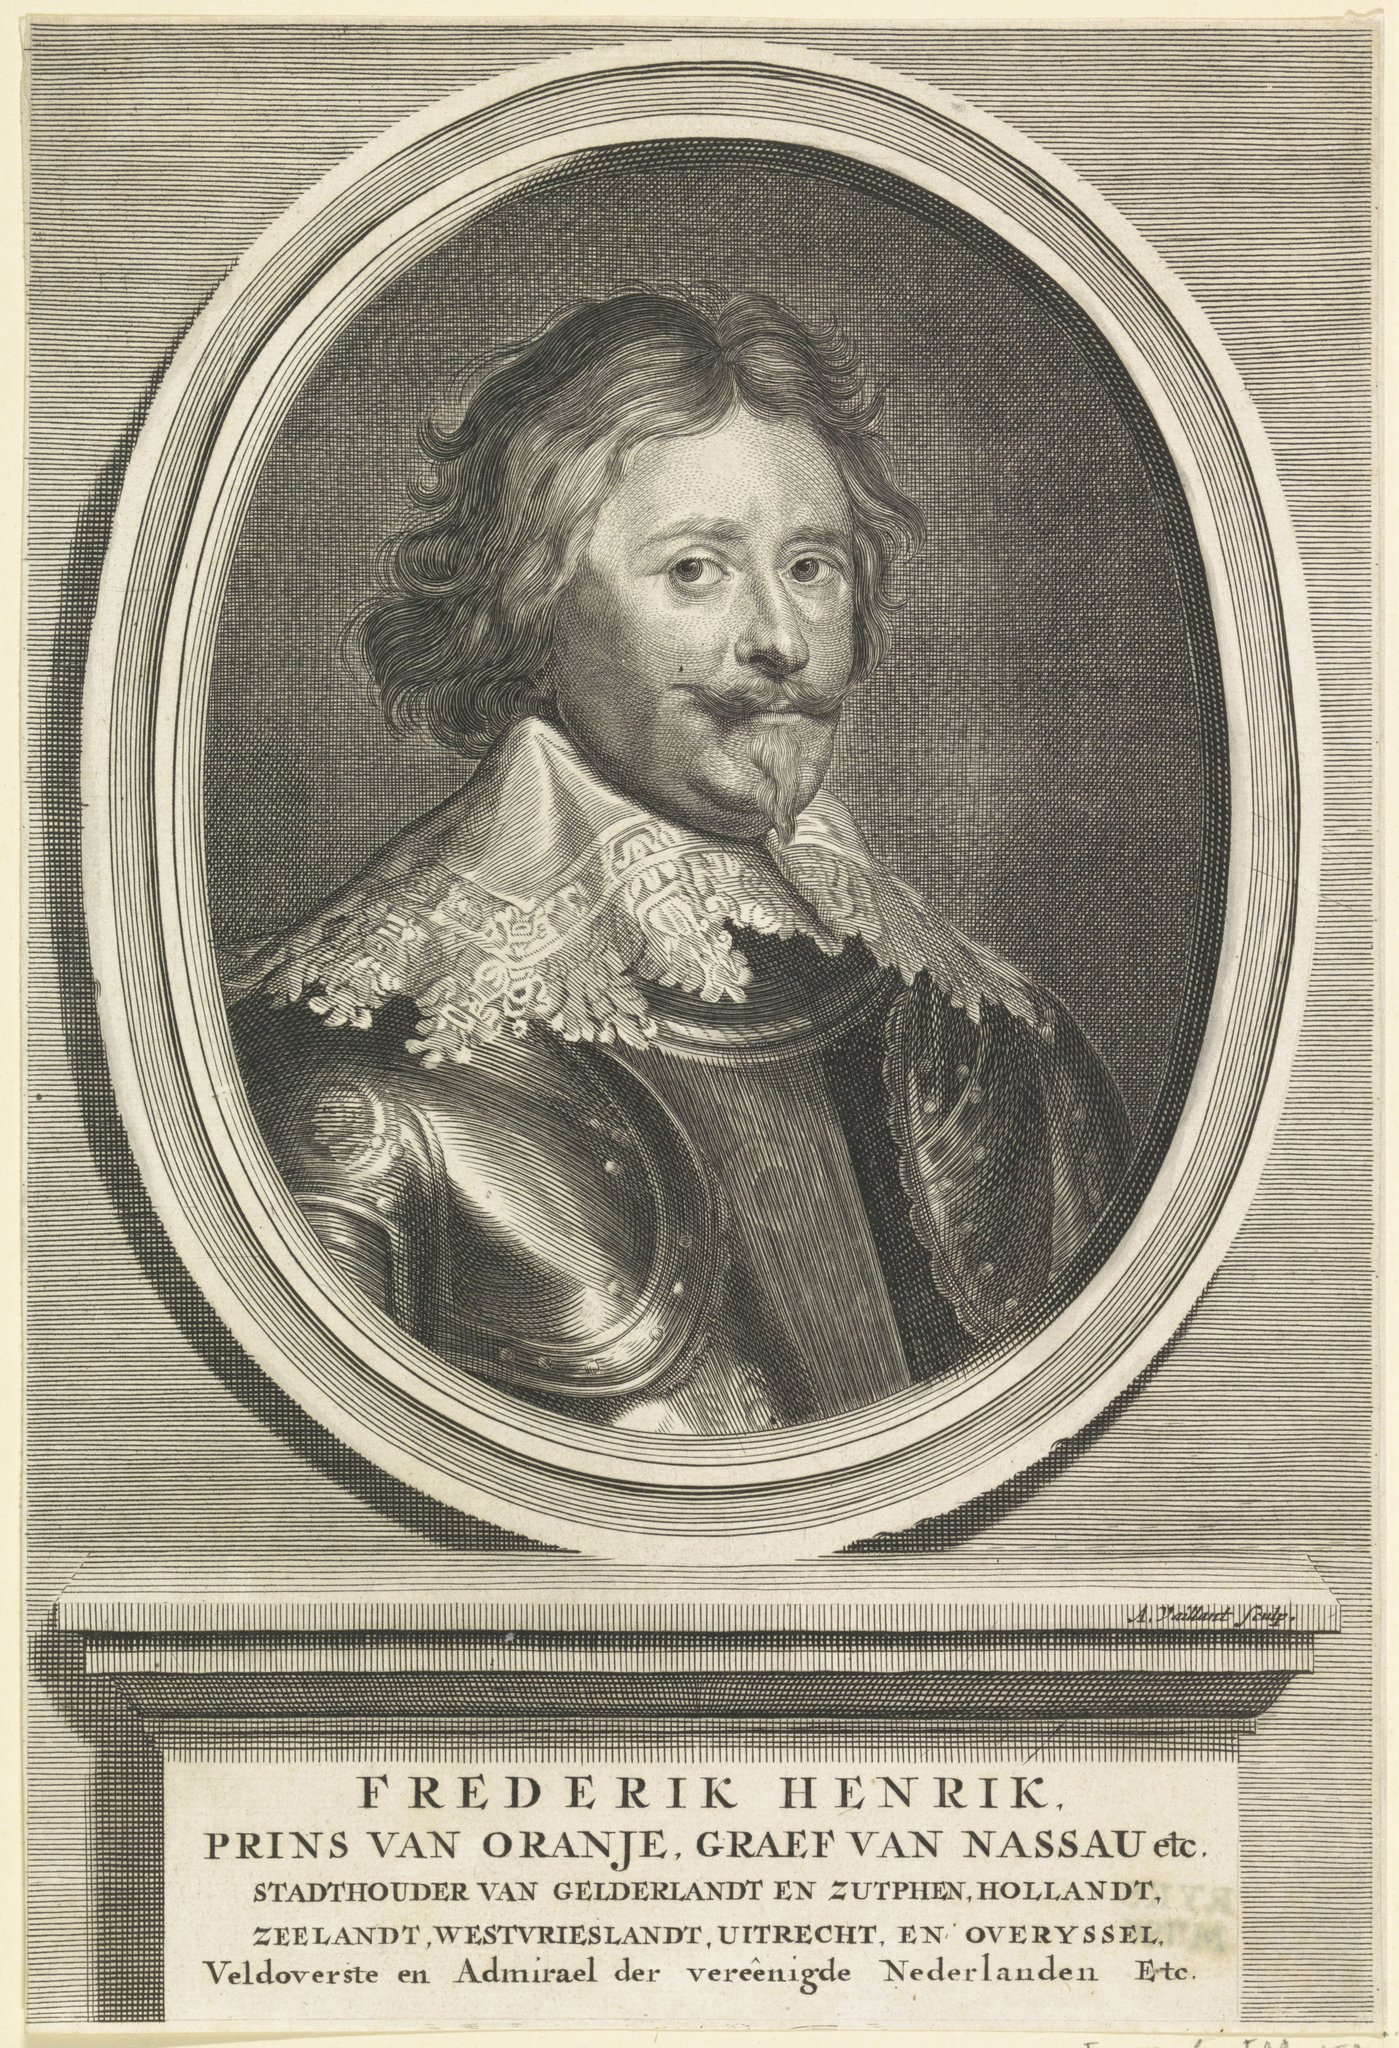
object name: print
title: Portret van Frederik Hendrik, prins van Oranje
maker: andries vaillant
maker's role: print maker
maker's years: 1655-1693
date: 1675-1693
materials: paper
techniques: engraving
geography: low countries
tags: delft, the hague, frederick henry (prince of orange)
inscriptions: collector's mark: Lugt 2165, collector's mark: Lugt 963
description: De hier vermelde titel verwijst naar de hoogst verkregen titel van de geportretteerde, niet per se naar de titel die de geportretteerde op deze voorstelling draagt.